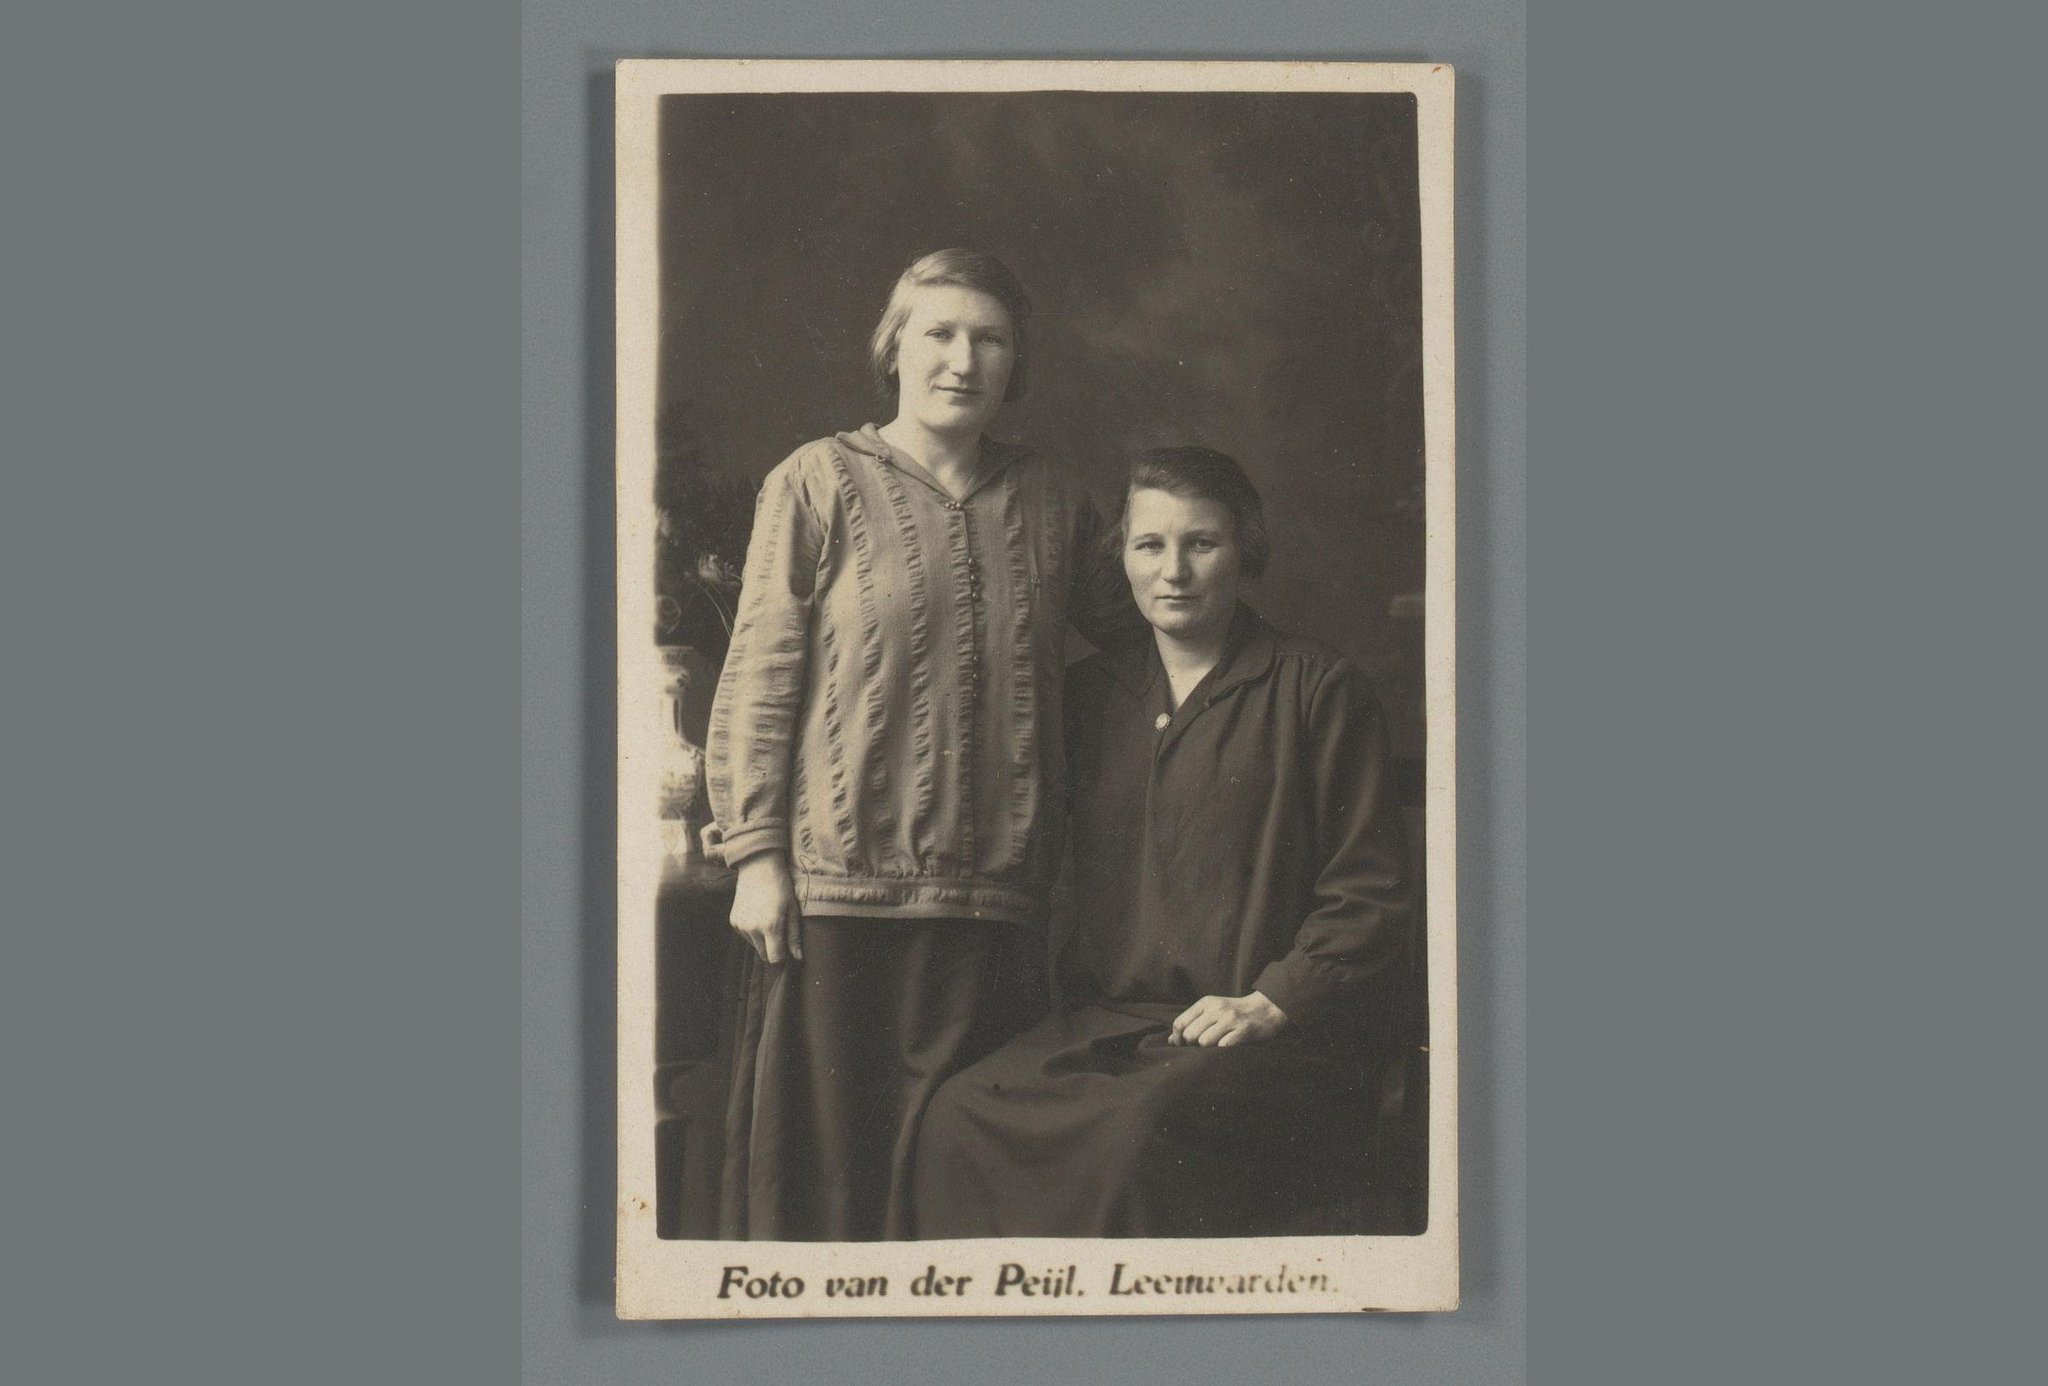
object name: photograph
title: Portret van twee onbekende vrouwen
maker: jacobus marinus van der peijl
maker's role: fotograaf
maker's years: 1883-1947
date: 1905-1928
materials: paper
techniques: gelatin silver print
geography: leeuwarden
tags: historical persons not known by name - bb - woman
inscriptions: inscription: ‘Foto van der Peijl, Leeuwarden’